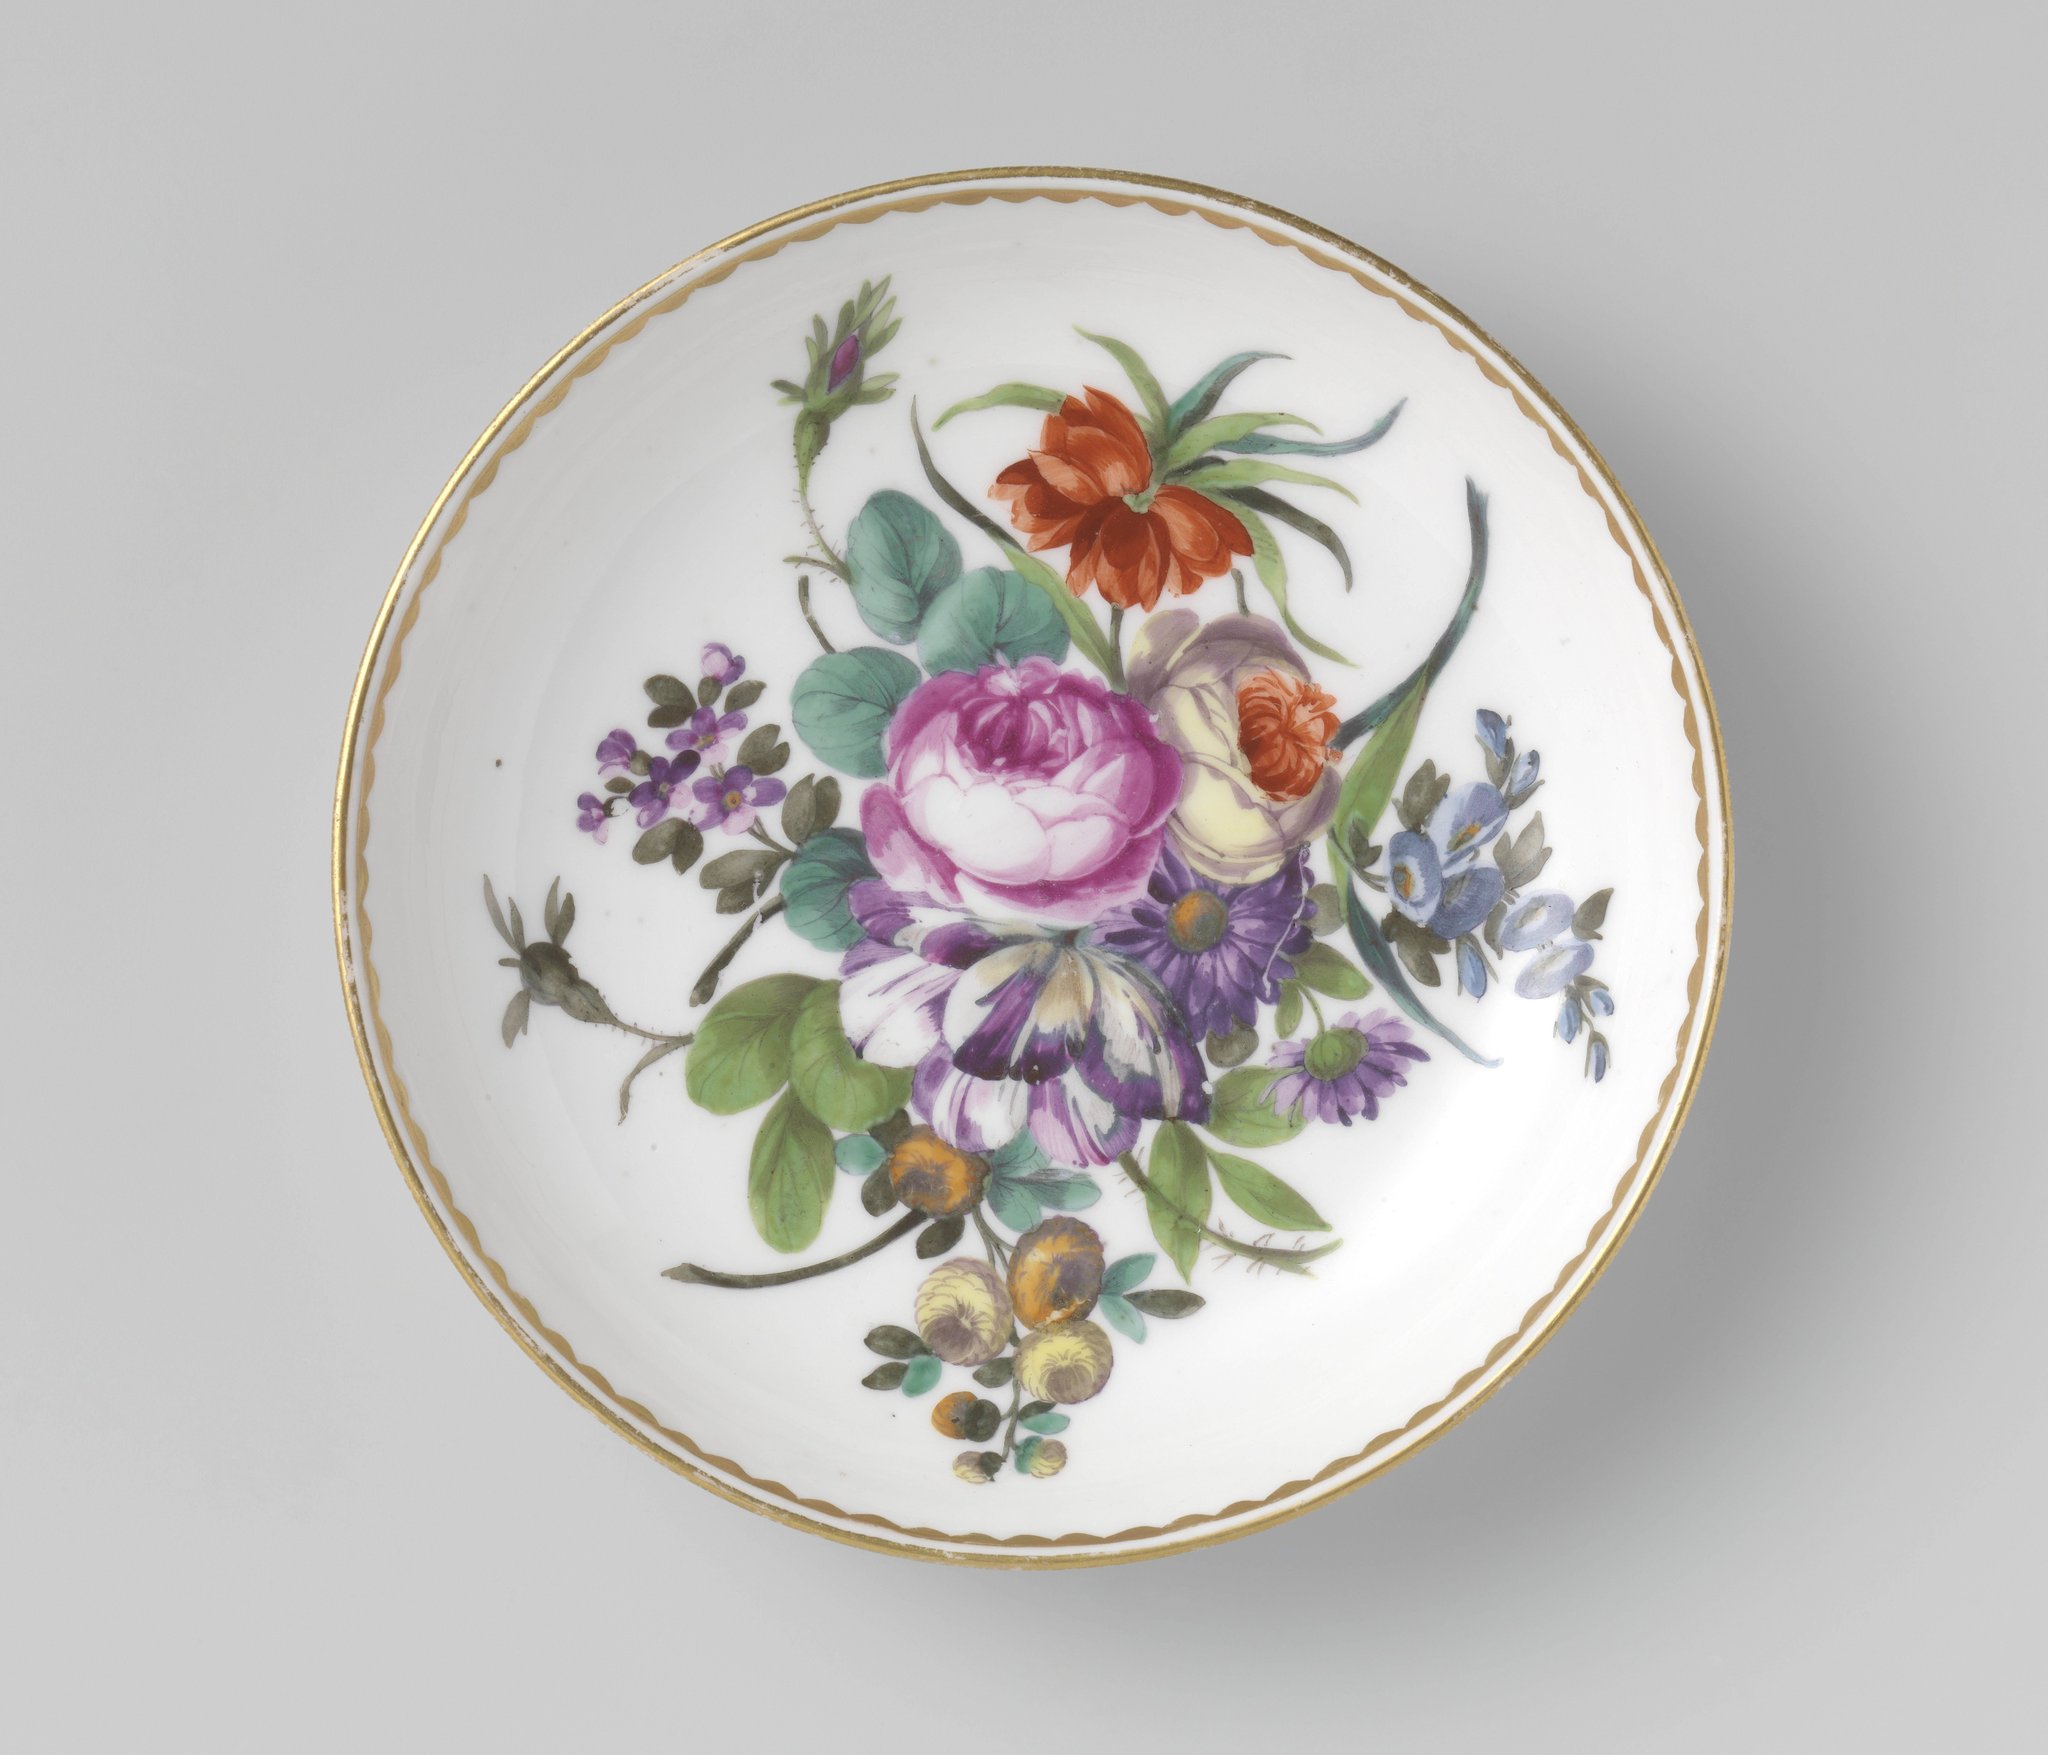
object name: platter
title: Tea service for two people (tête-à-tête)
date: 1778-1782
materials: porcelain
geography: loosdrecht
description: Manufactuur Oud-Loosdrecht Loosdrecht, c. 1778–1782 hard-paste porcelain